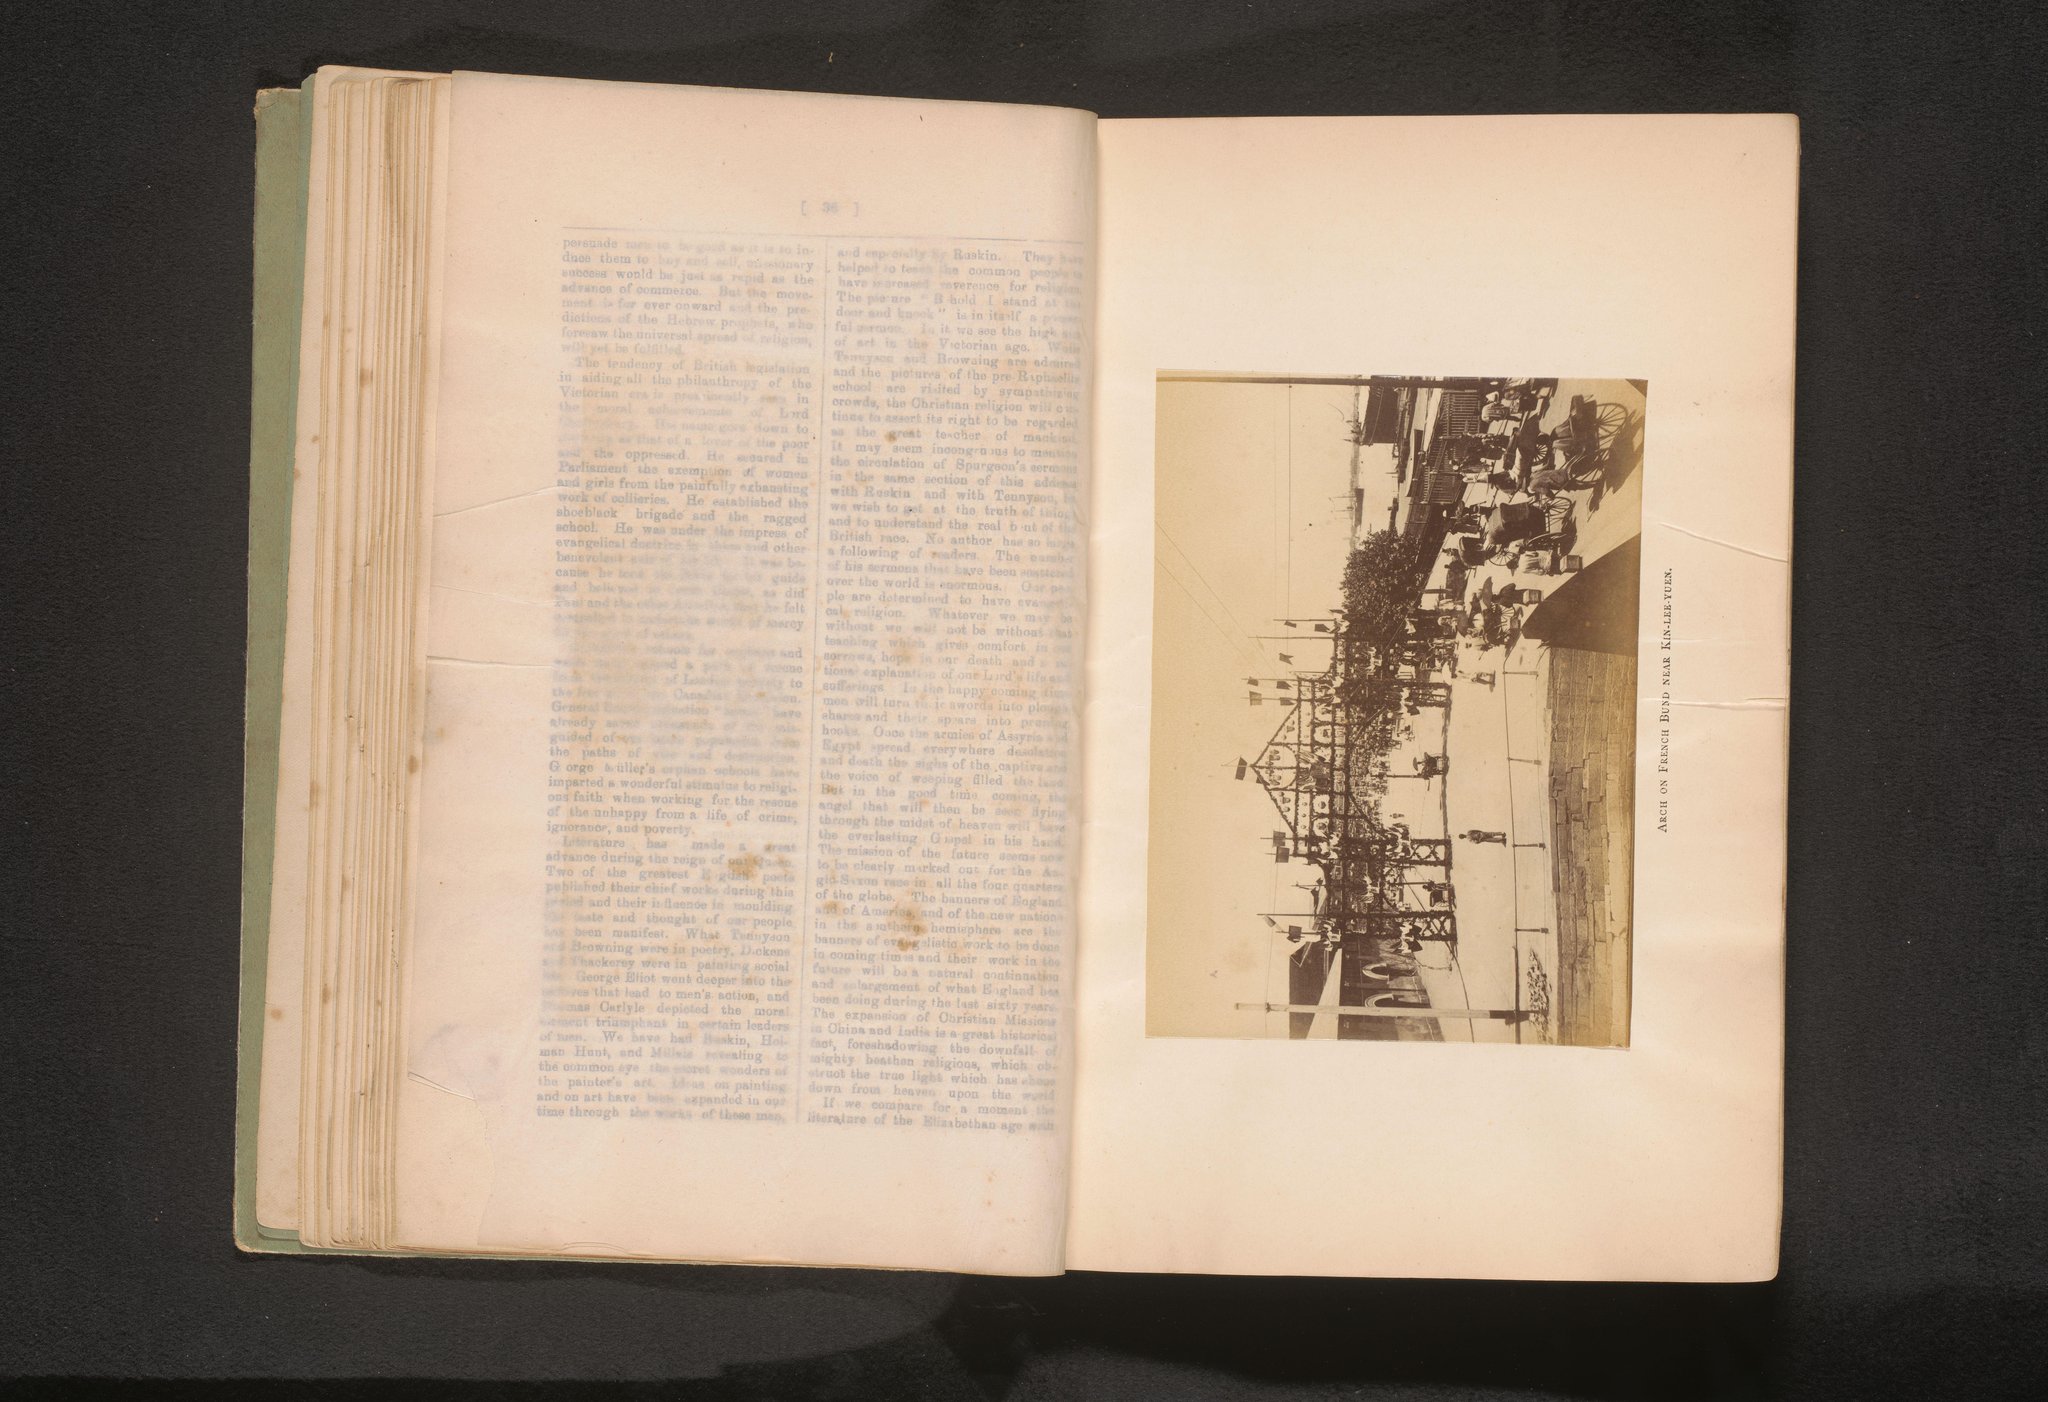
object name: photograph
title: Arch on French Bund near Kin-Lee-Yuen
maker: w.r. kahler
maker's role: fotograaf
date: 1897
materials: photographic support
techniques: albumen print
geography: shanghai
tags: hand-cart, festivities (+ wreath, garland ~ festive activities), commemoration, jubilee